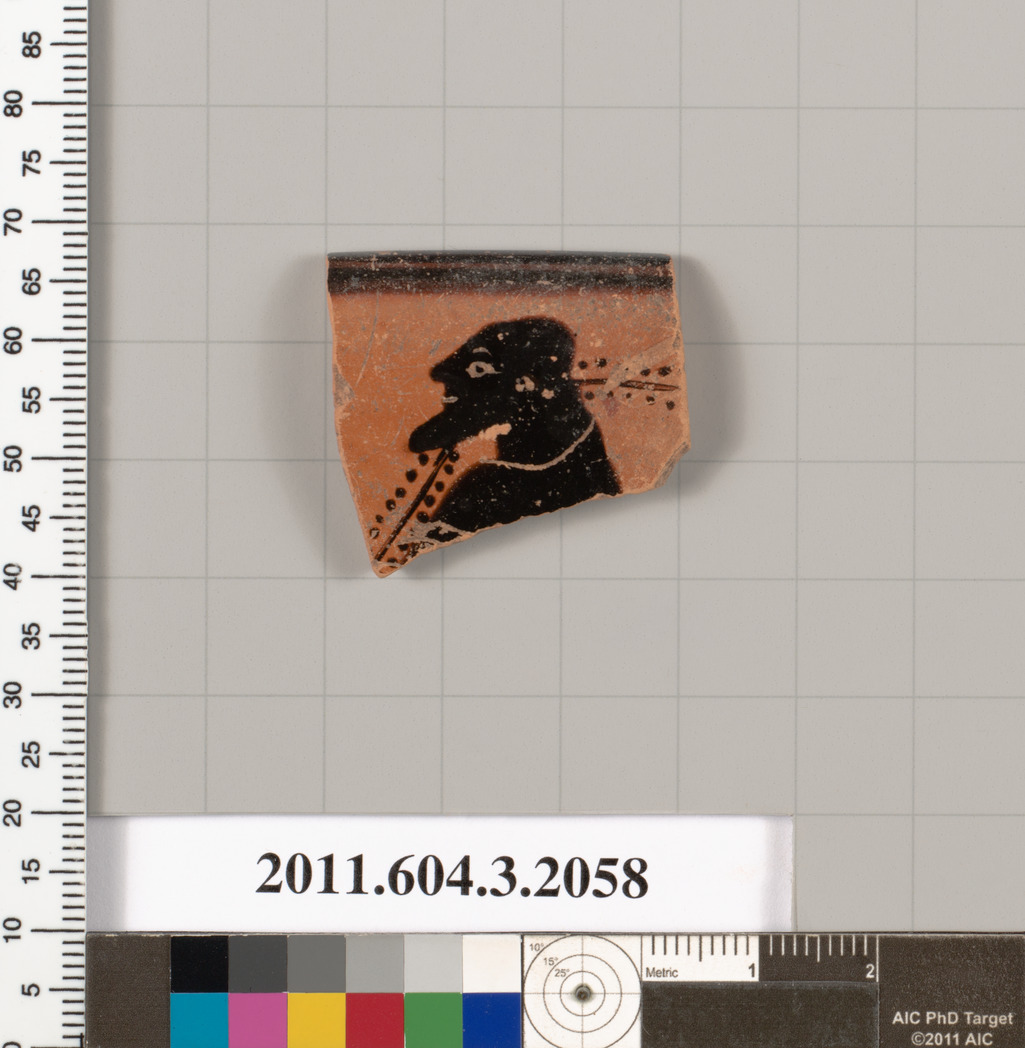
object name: kylix fragment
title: Terracotta rim fragment of a kylix (drinking cup)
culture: greek, attic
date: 500-480 BCE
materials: terracotta